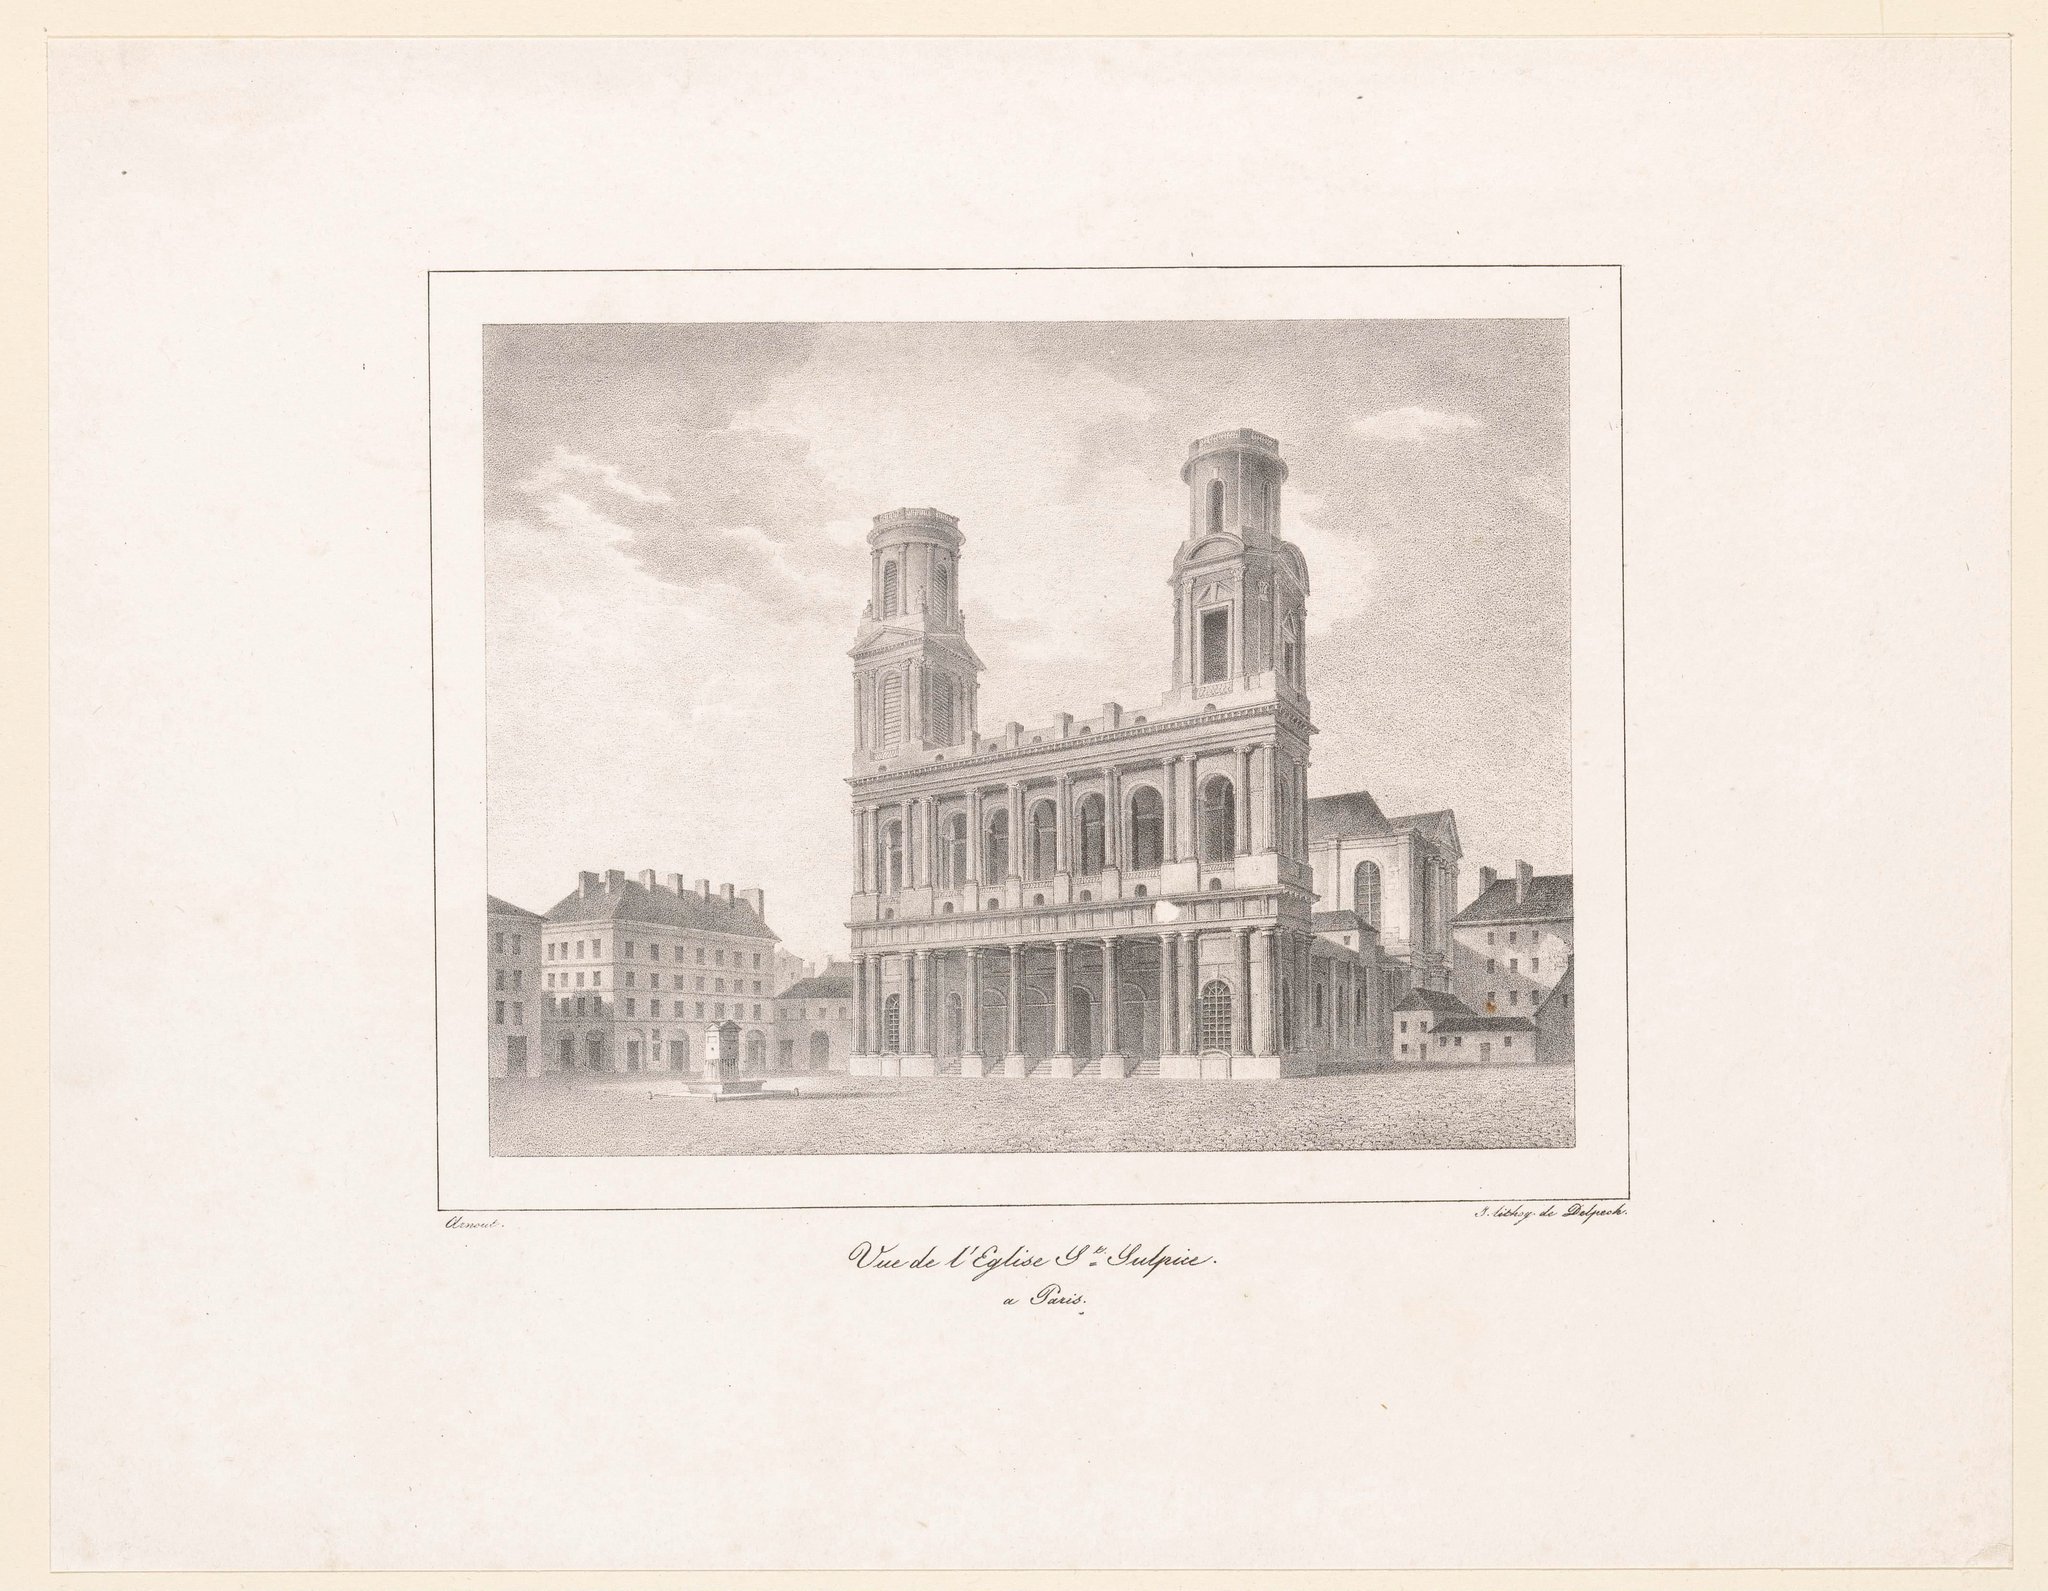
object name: print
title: Zicht op de kerk Saint-Sulpice in Parijs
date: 1820-1821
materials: paper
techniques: lithograph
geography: paris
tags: church (exterior), paris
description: De serie waar deze prent deel van uit maakt, bestaat waarschijnlijk uit dertig prenten.